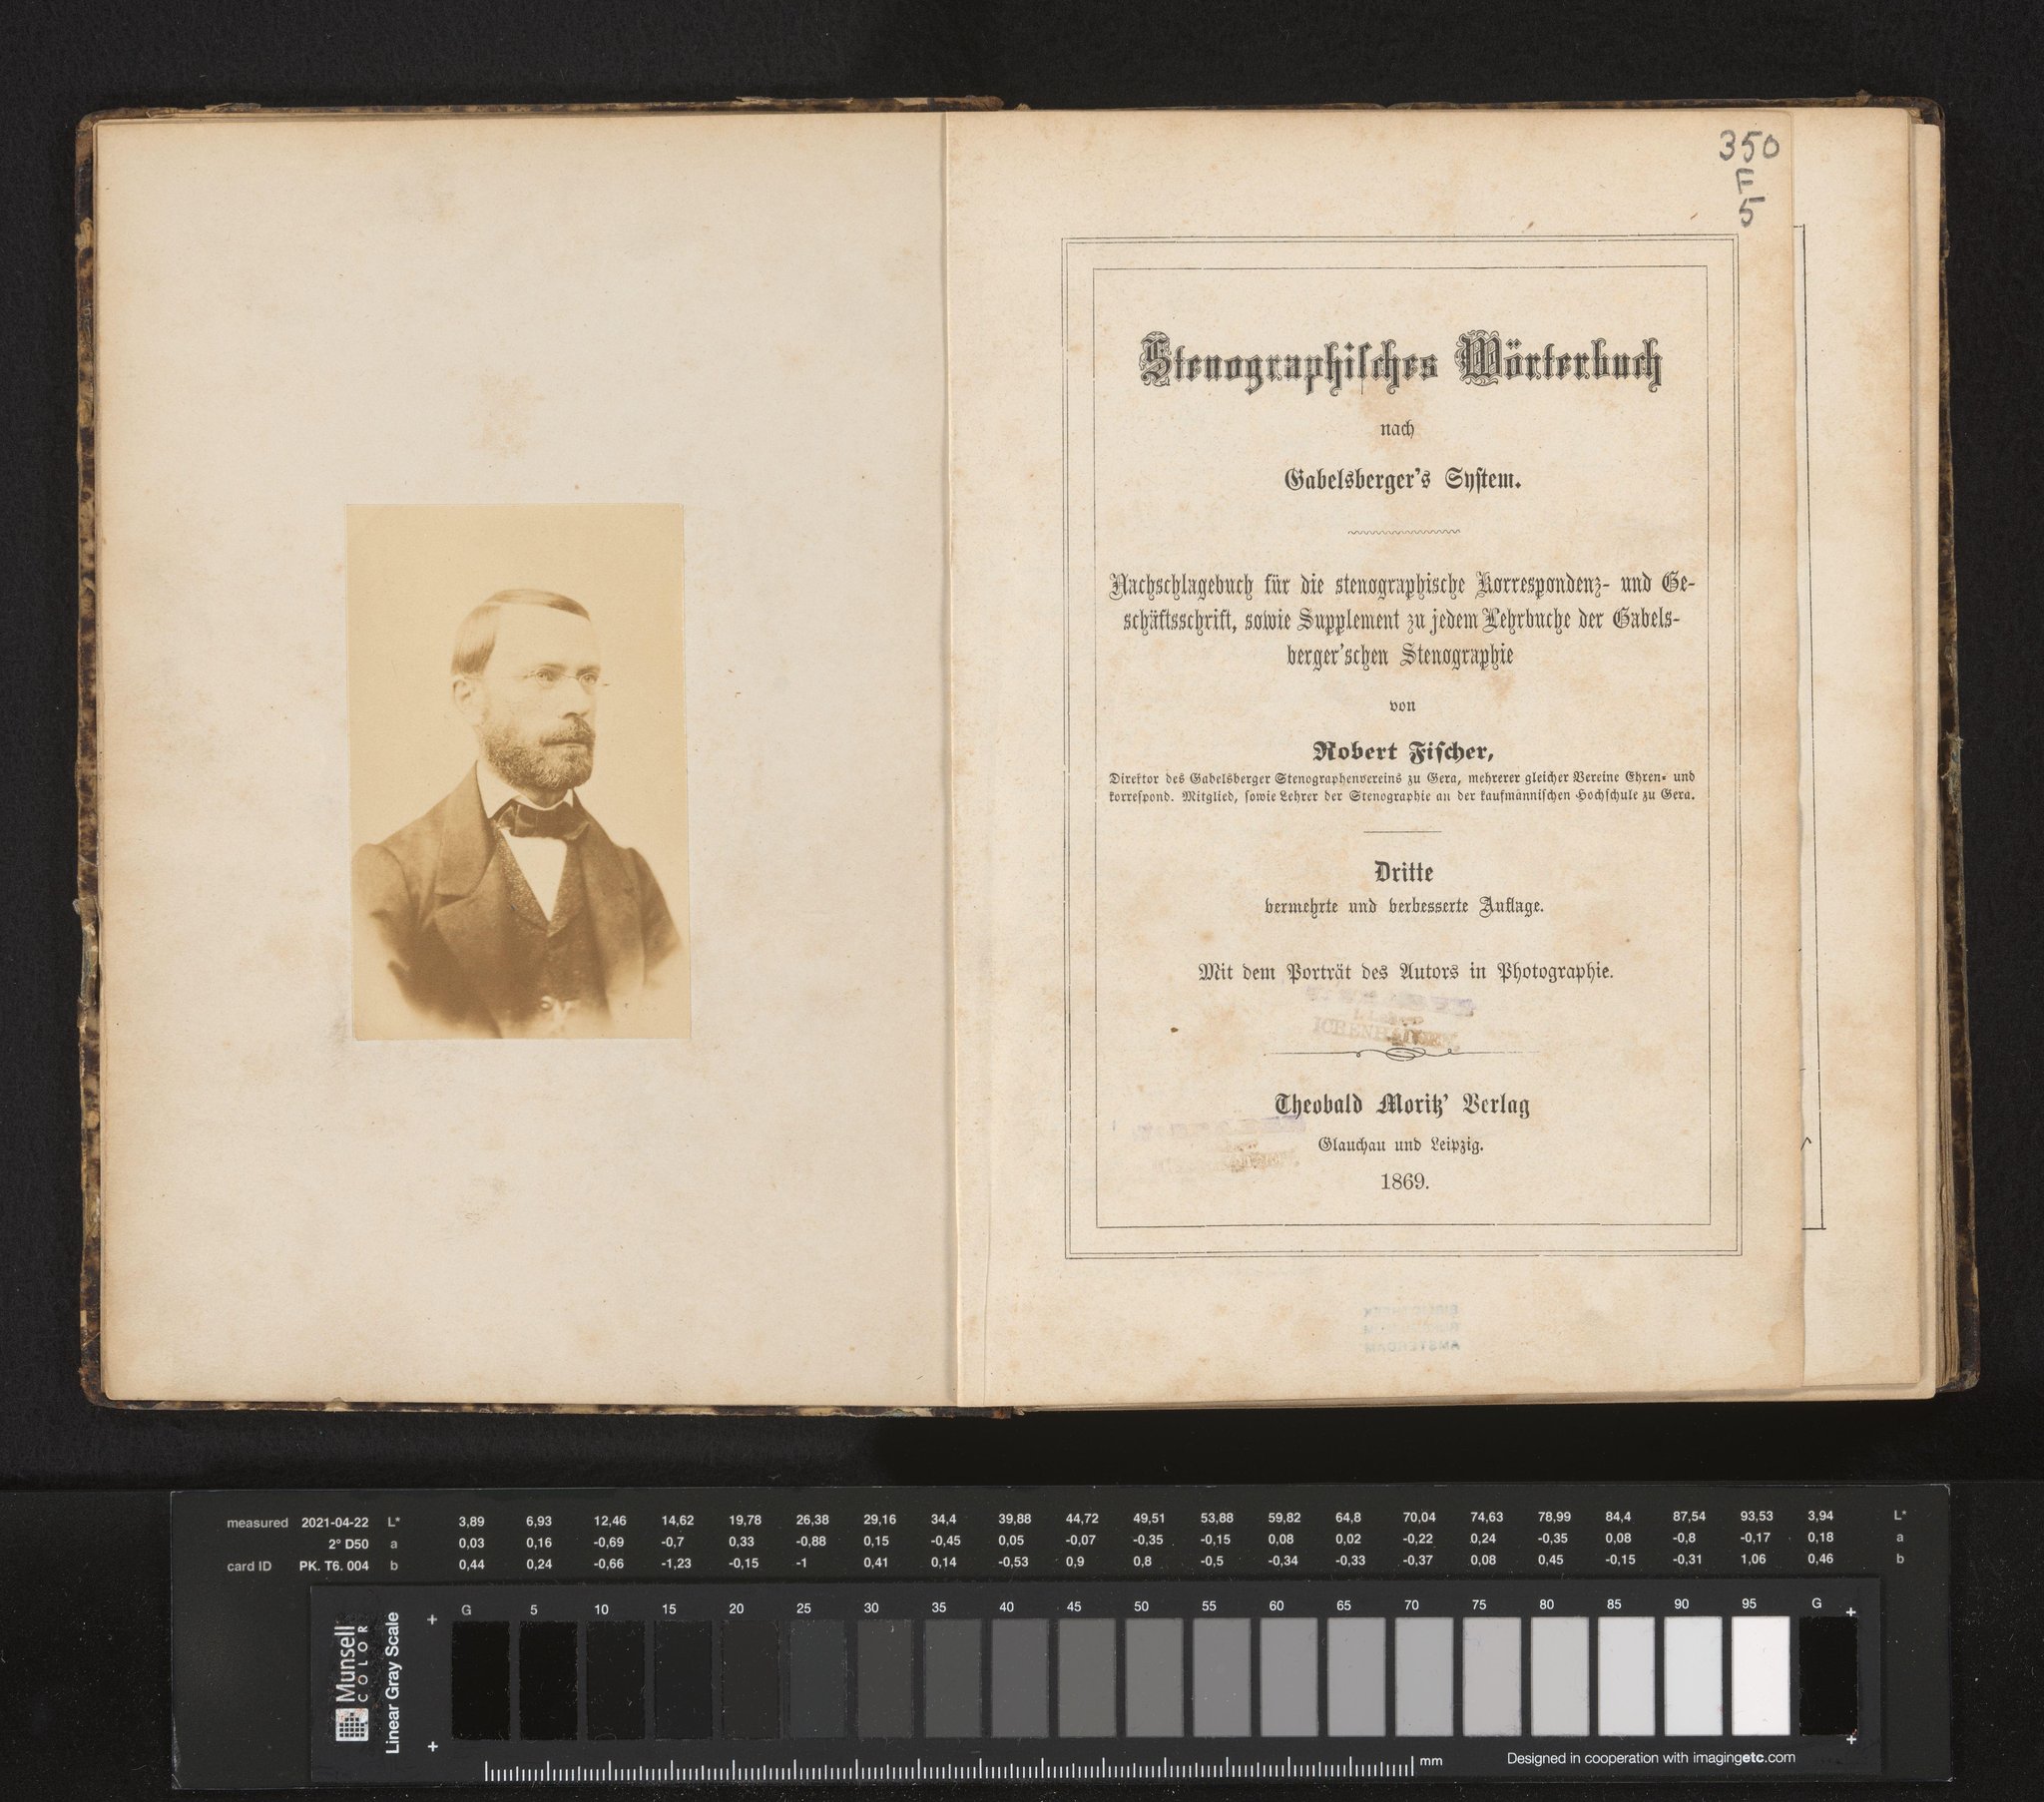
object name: page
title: Portret van Robert Fischer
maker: Anonymous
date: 1864-1869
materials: paper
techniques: albumen print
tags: robert fischer, portrait of a writer